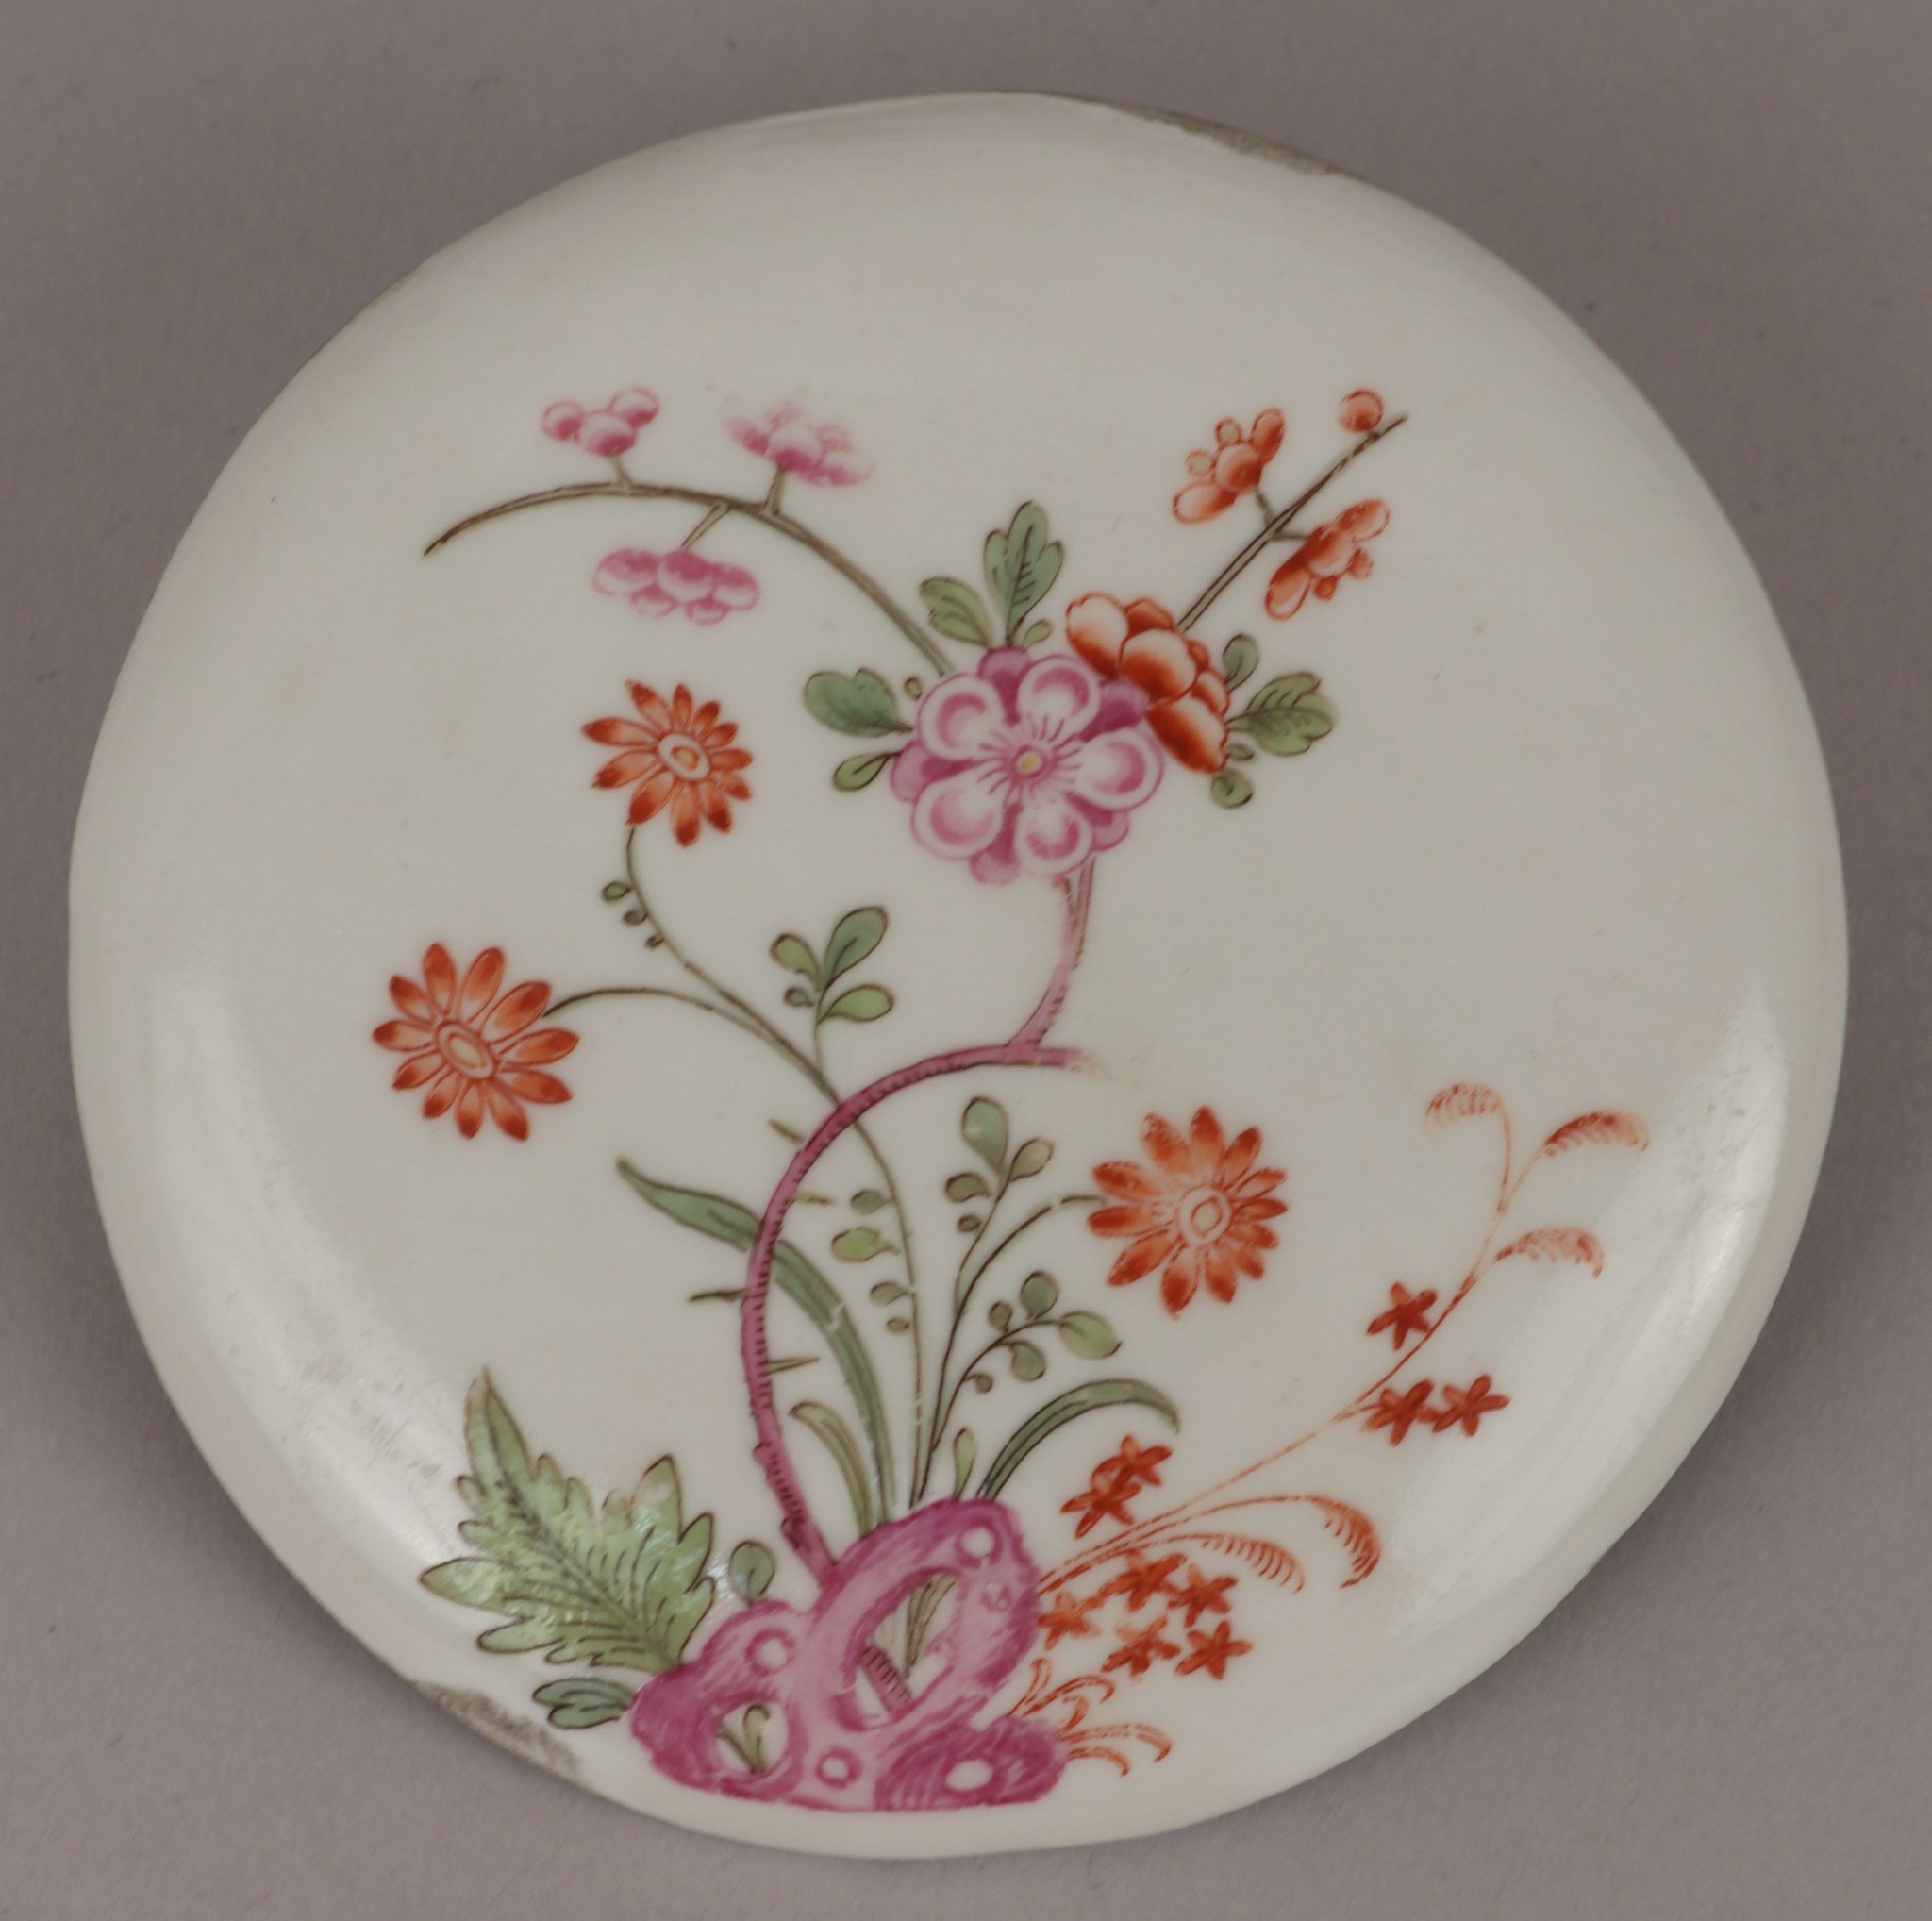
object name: plaque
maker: vienna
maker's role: manufactory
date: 1725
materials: hard paste porcelain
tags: flowers,leaves